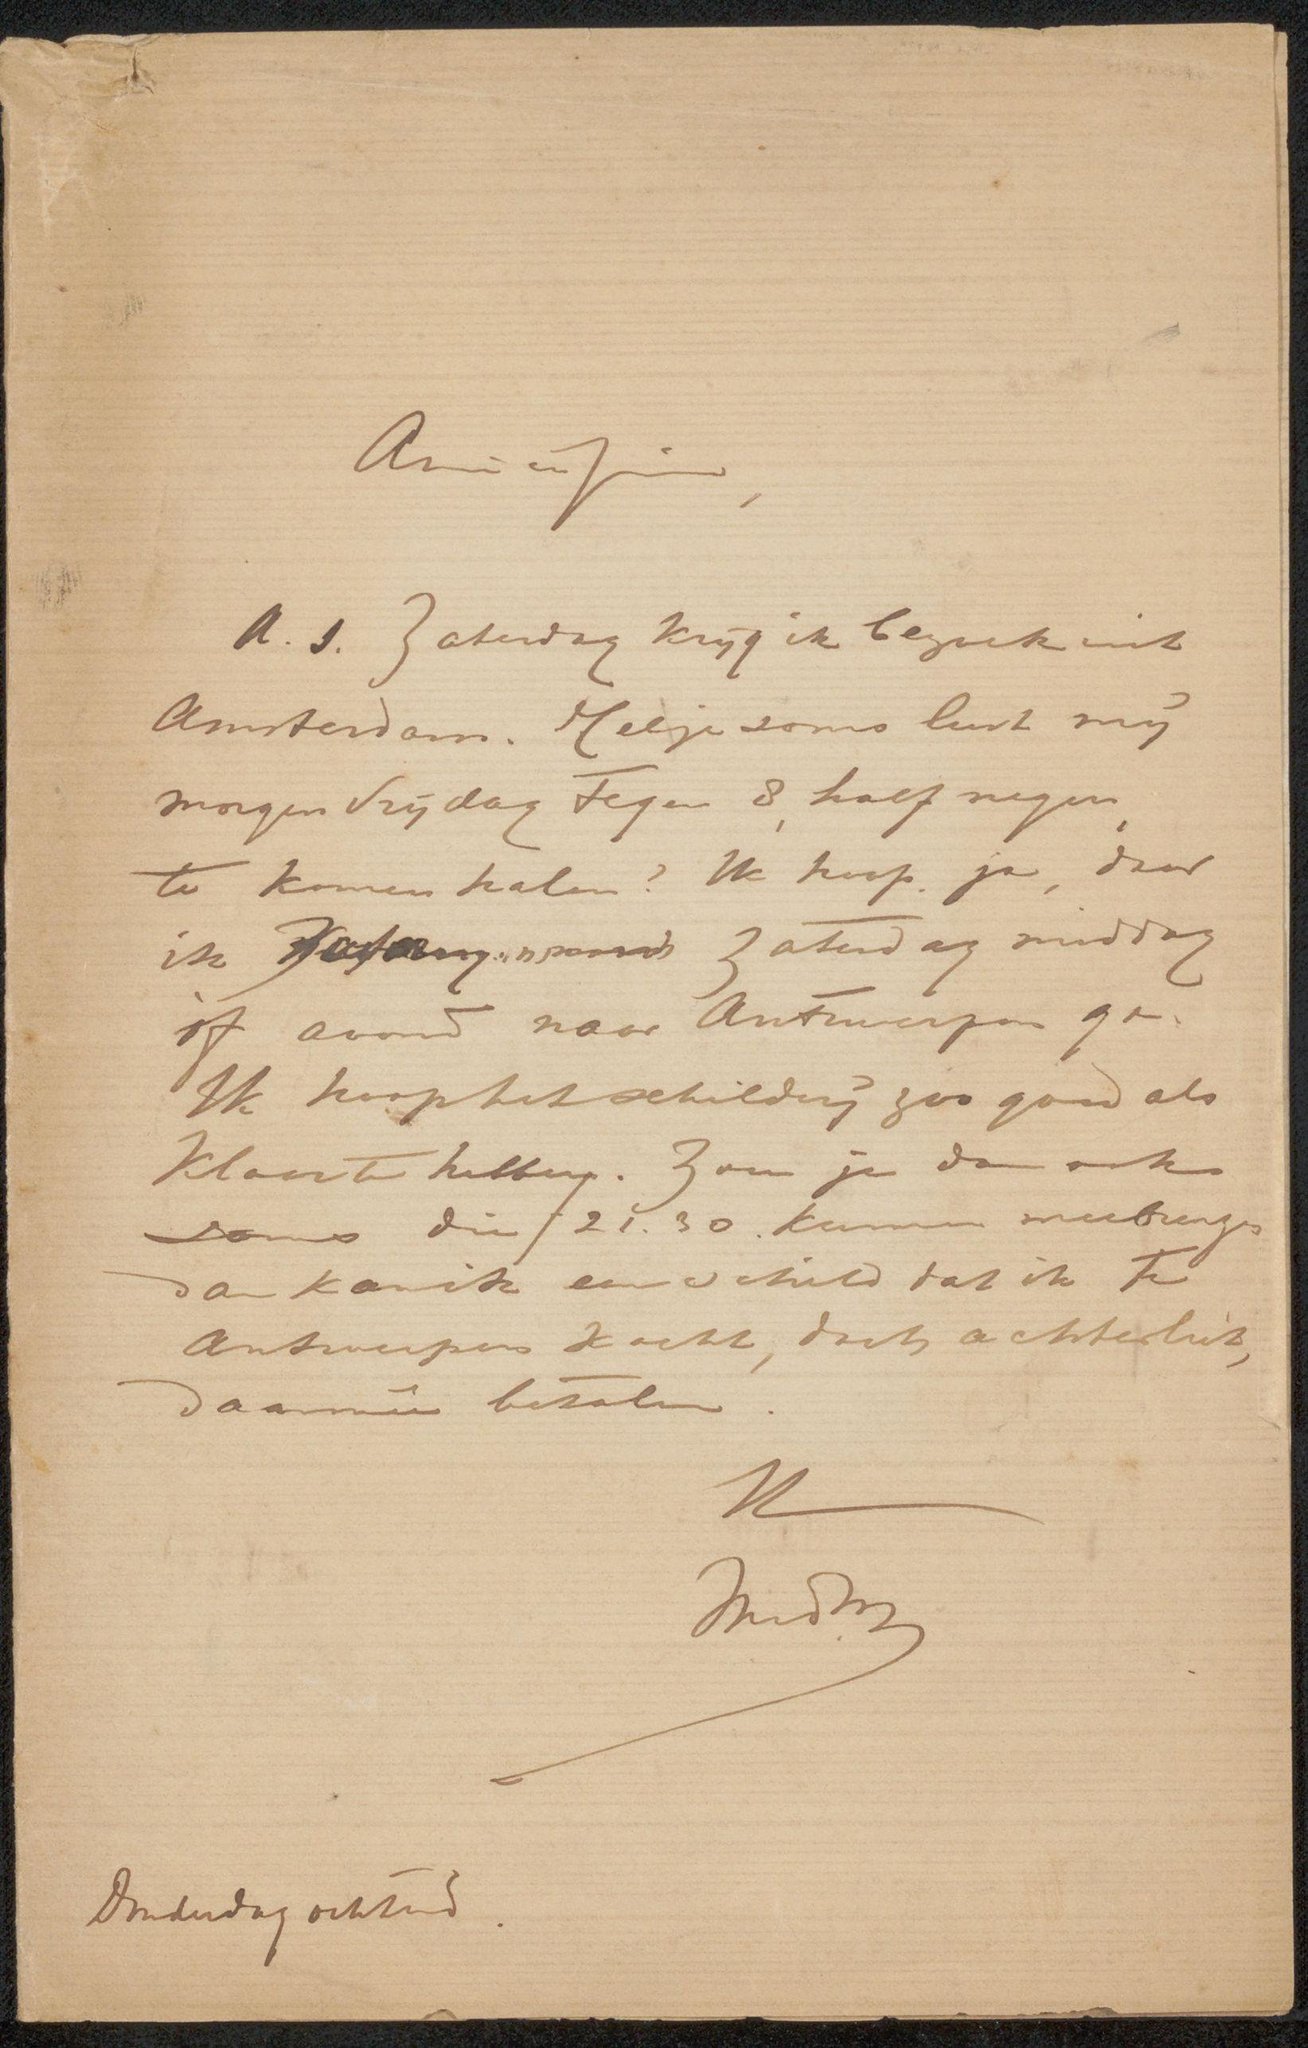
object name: letter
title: Brief aan Philip Zilcken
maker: marinus van der maarel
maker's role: draughtsman, painter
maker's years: 1857-1921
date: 1867-1921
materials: ink, paper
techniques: pen, writing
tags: philip zilcken, money, antwerp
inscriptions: collector's mark: ‘RPK’